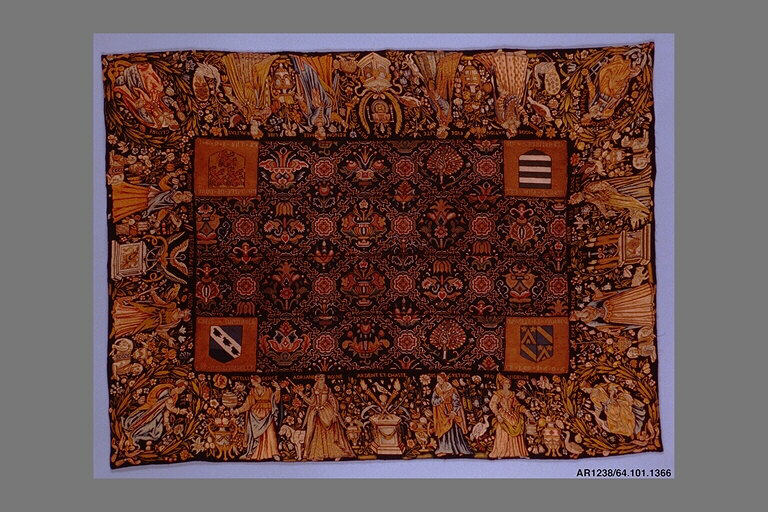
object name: table cover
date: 1606-1641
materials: canvas, silk, wool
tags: women,flowers